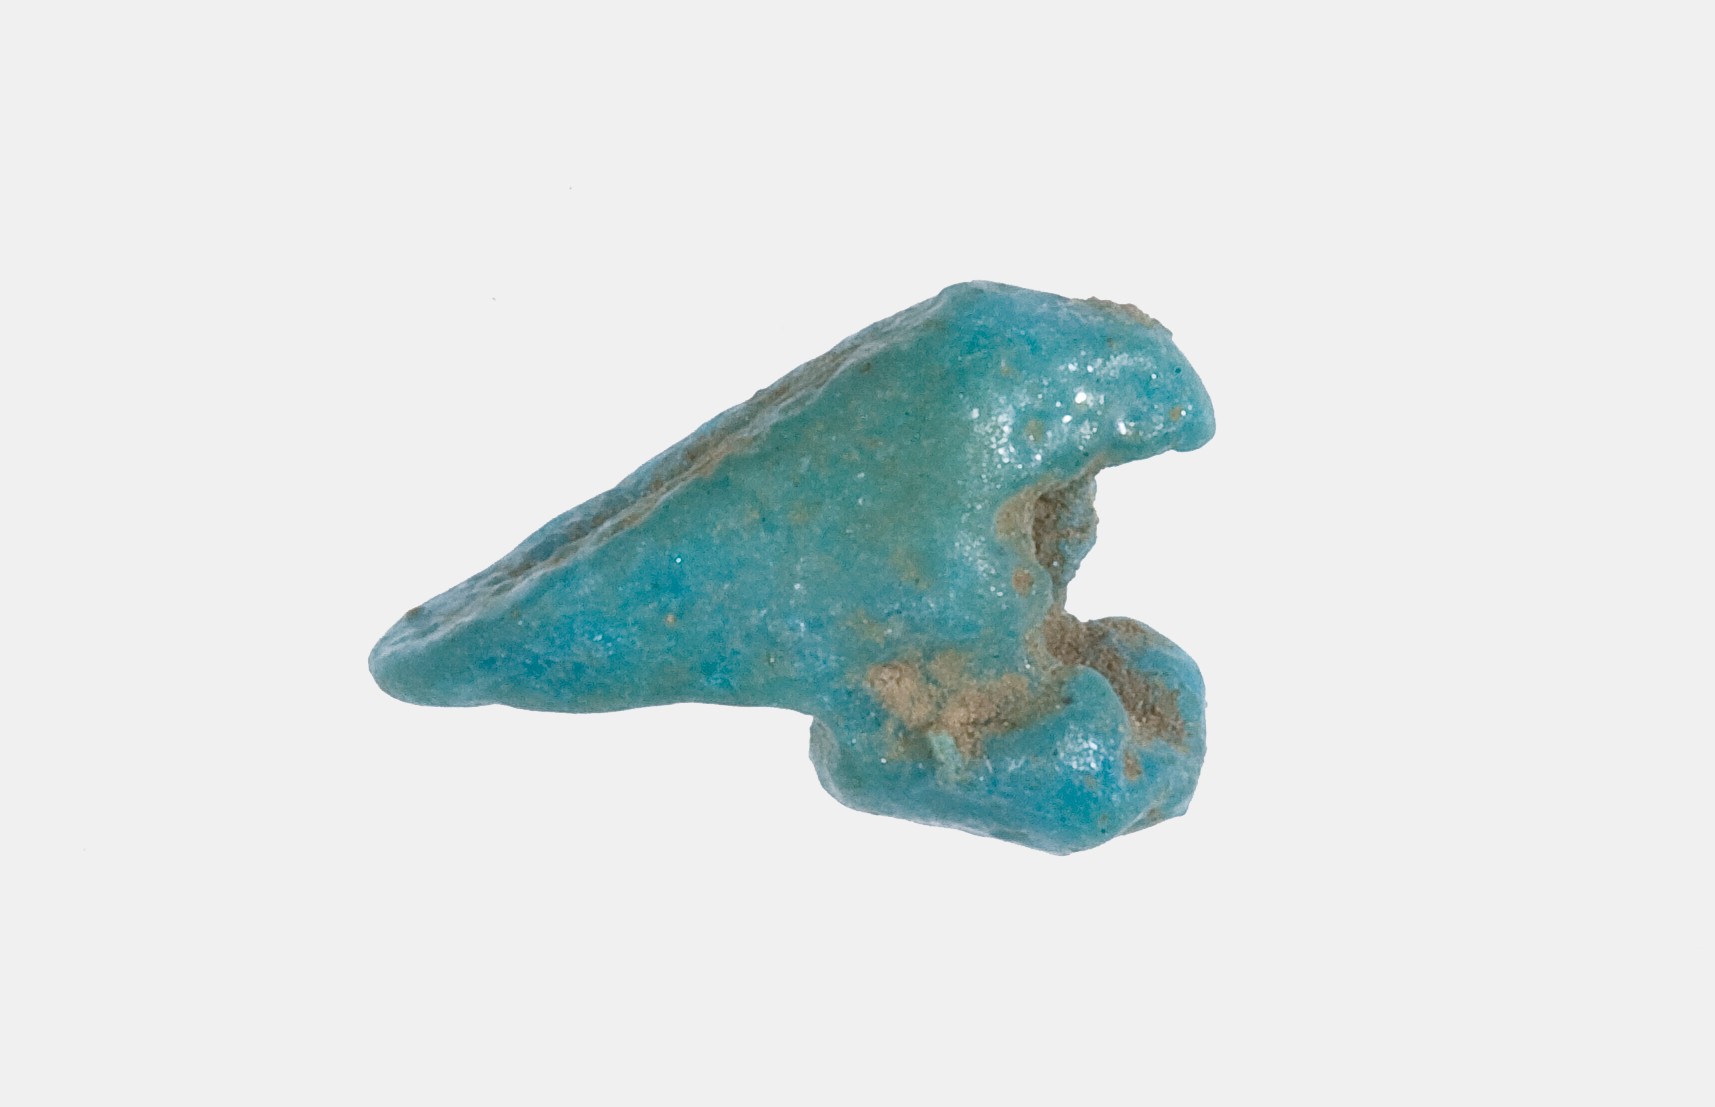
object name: amulet, falcon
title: Falcon Amulet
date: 1802-1450 BCE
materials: faience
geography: egypt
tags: falcons